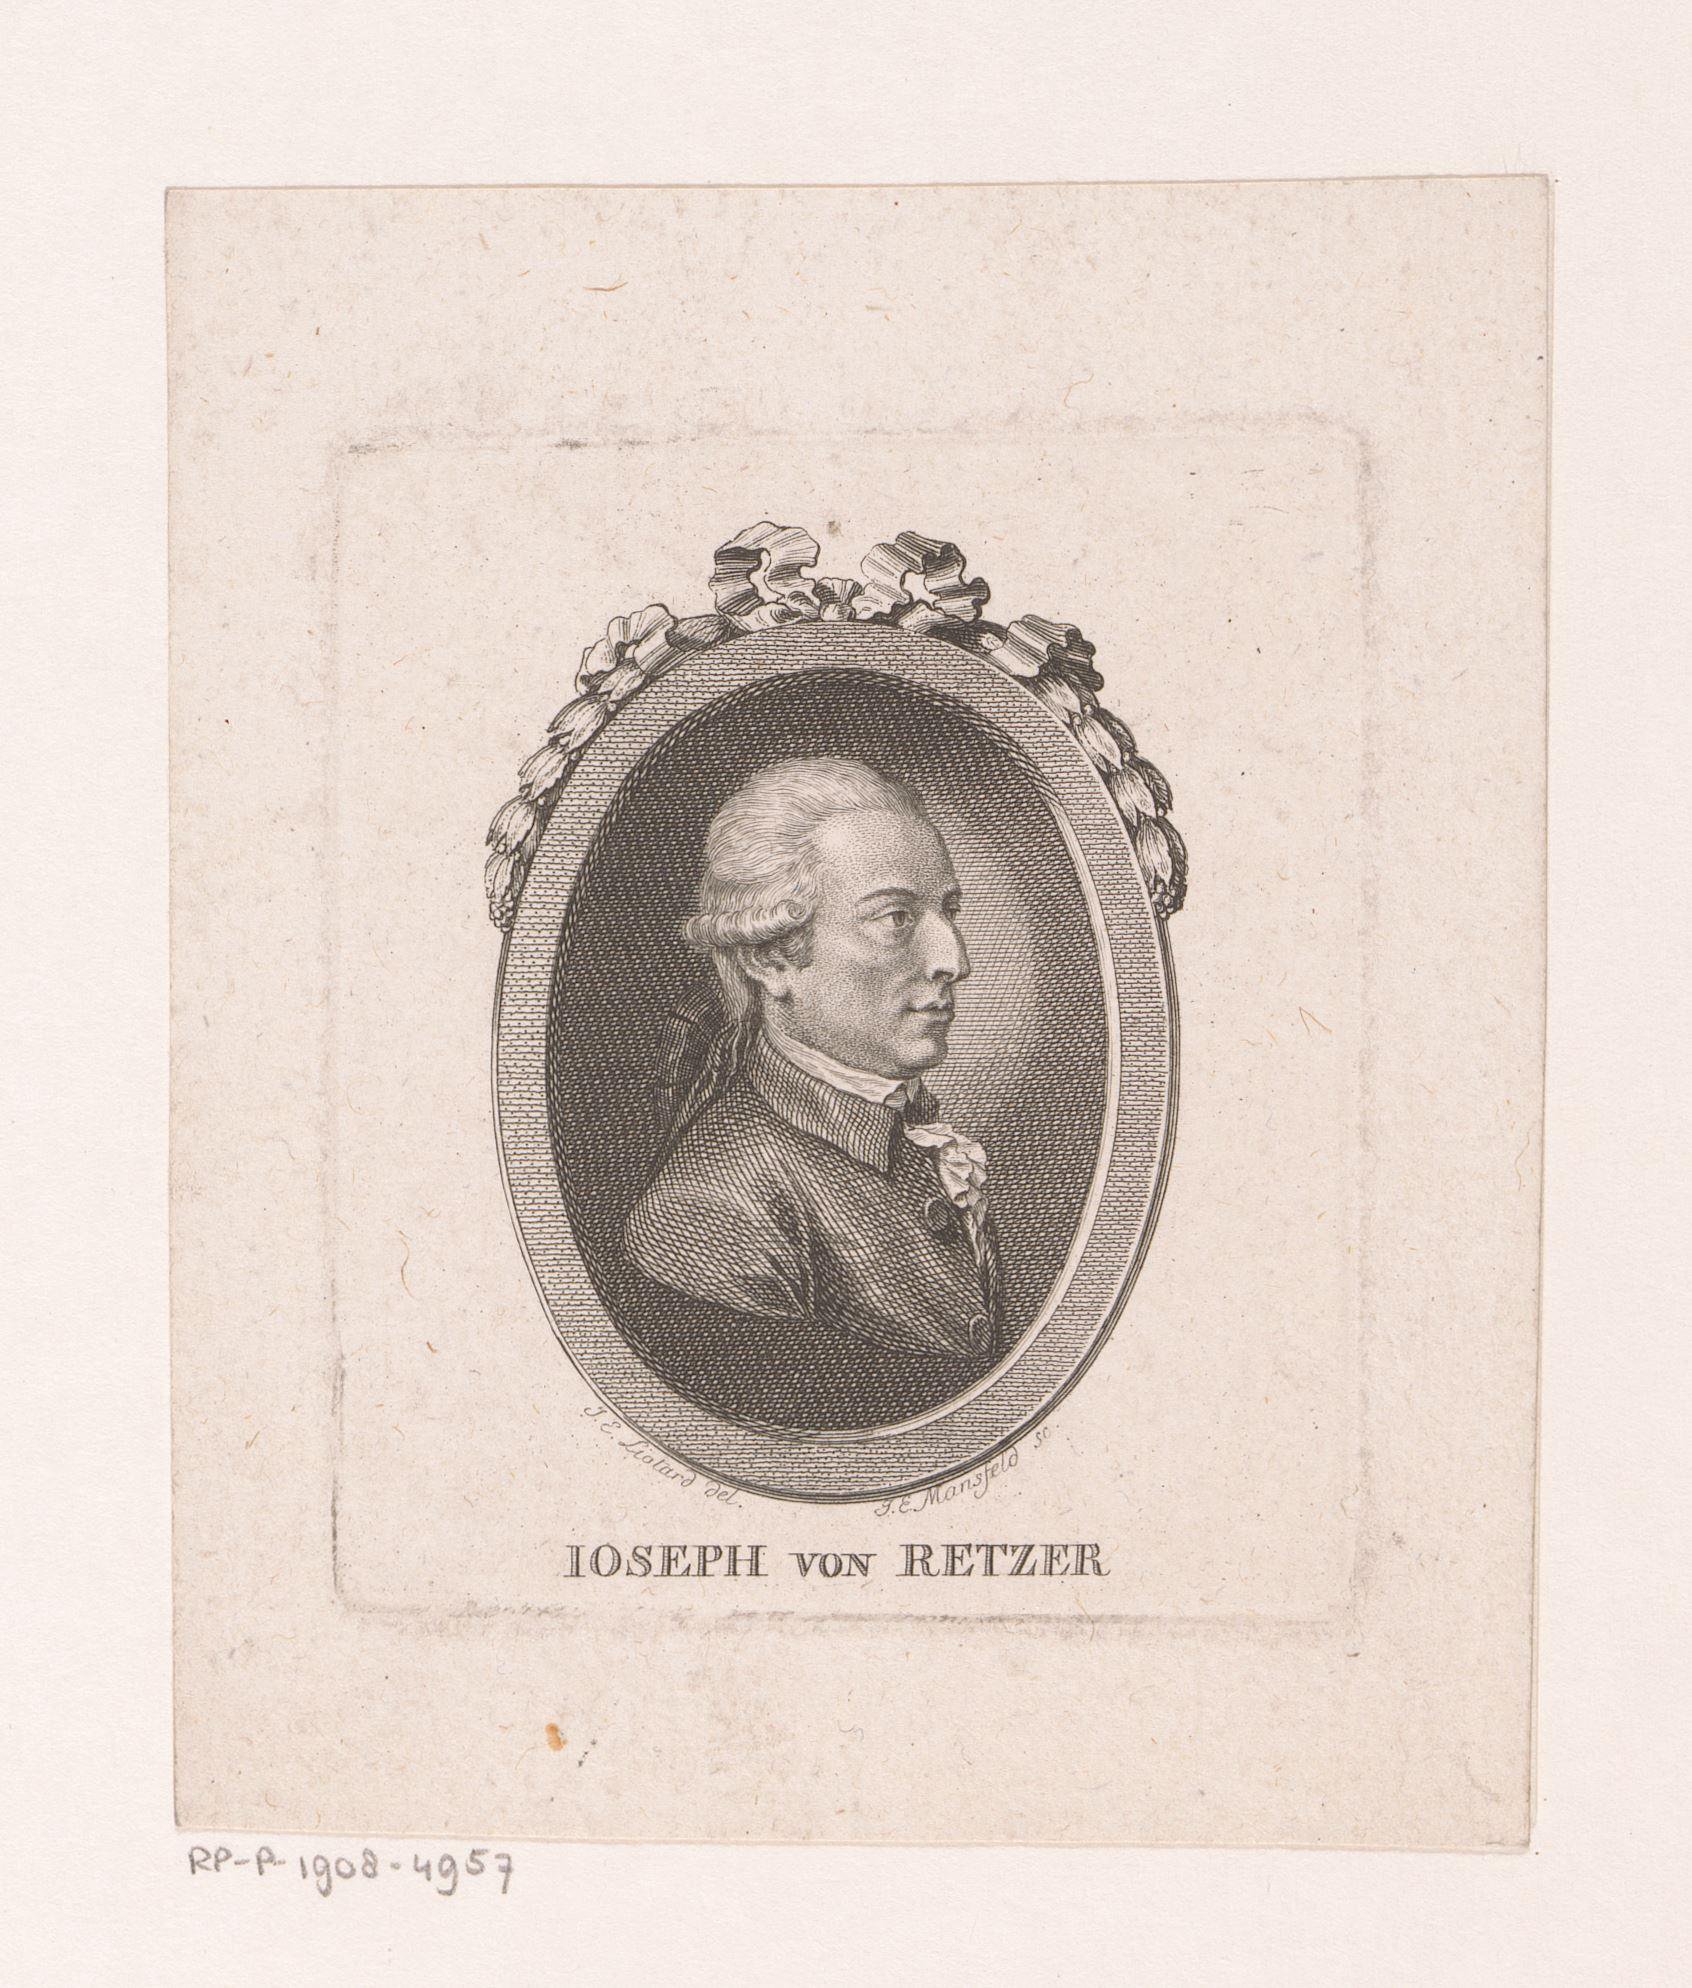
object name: print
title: Portret van Joseph Friedrich von Retzer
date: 1749-1796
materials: paper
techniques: engraving, etching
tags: vienna, historical persons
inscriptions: collector's mark: Lugt 2228